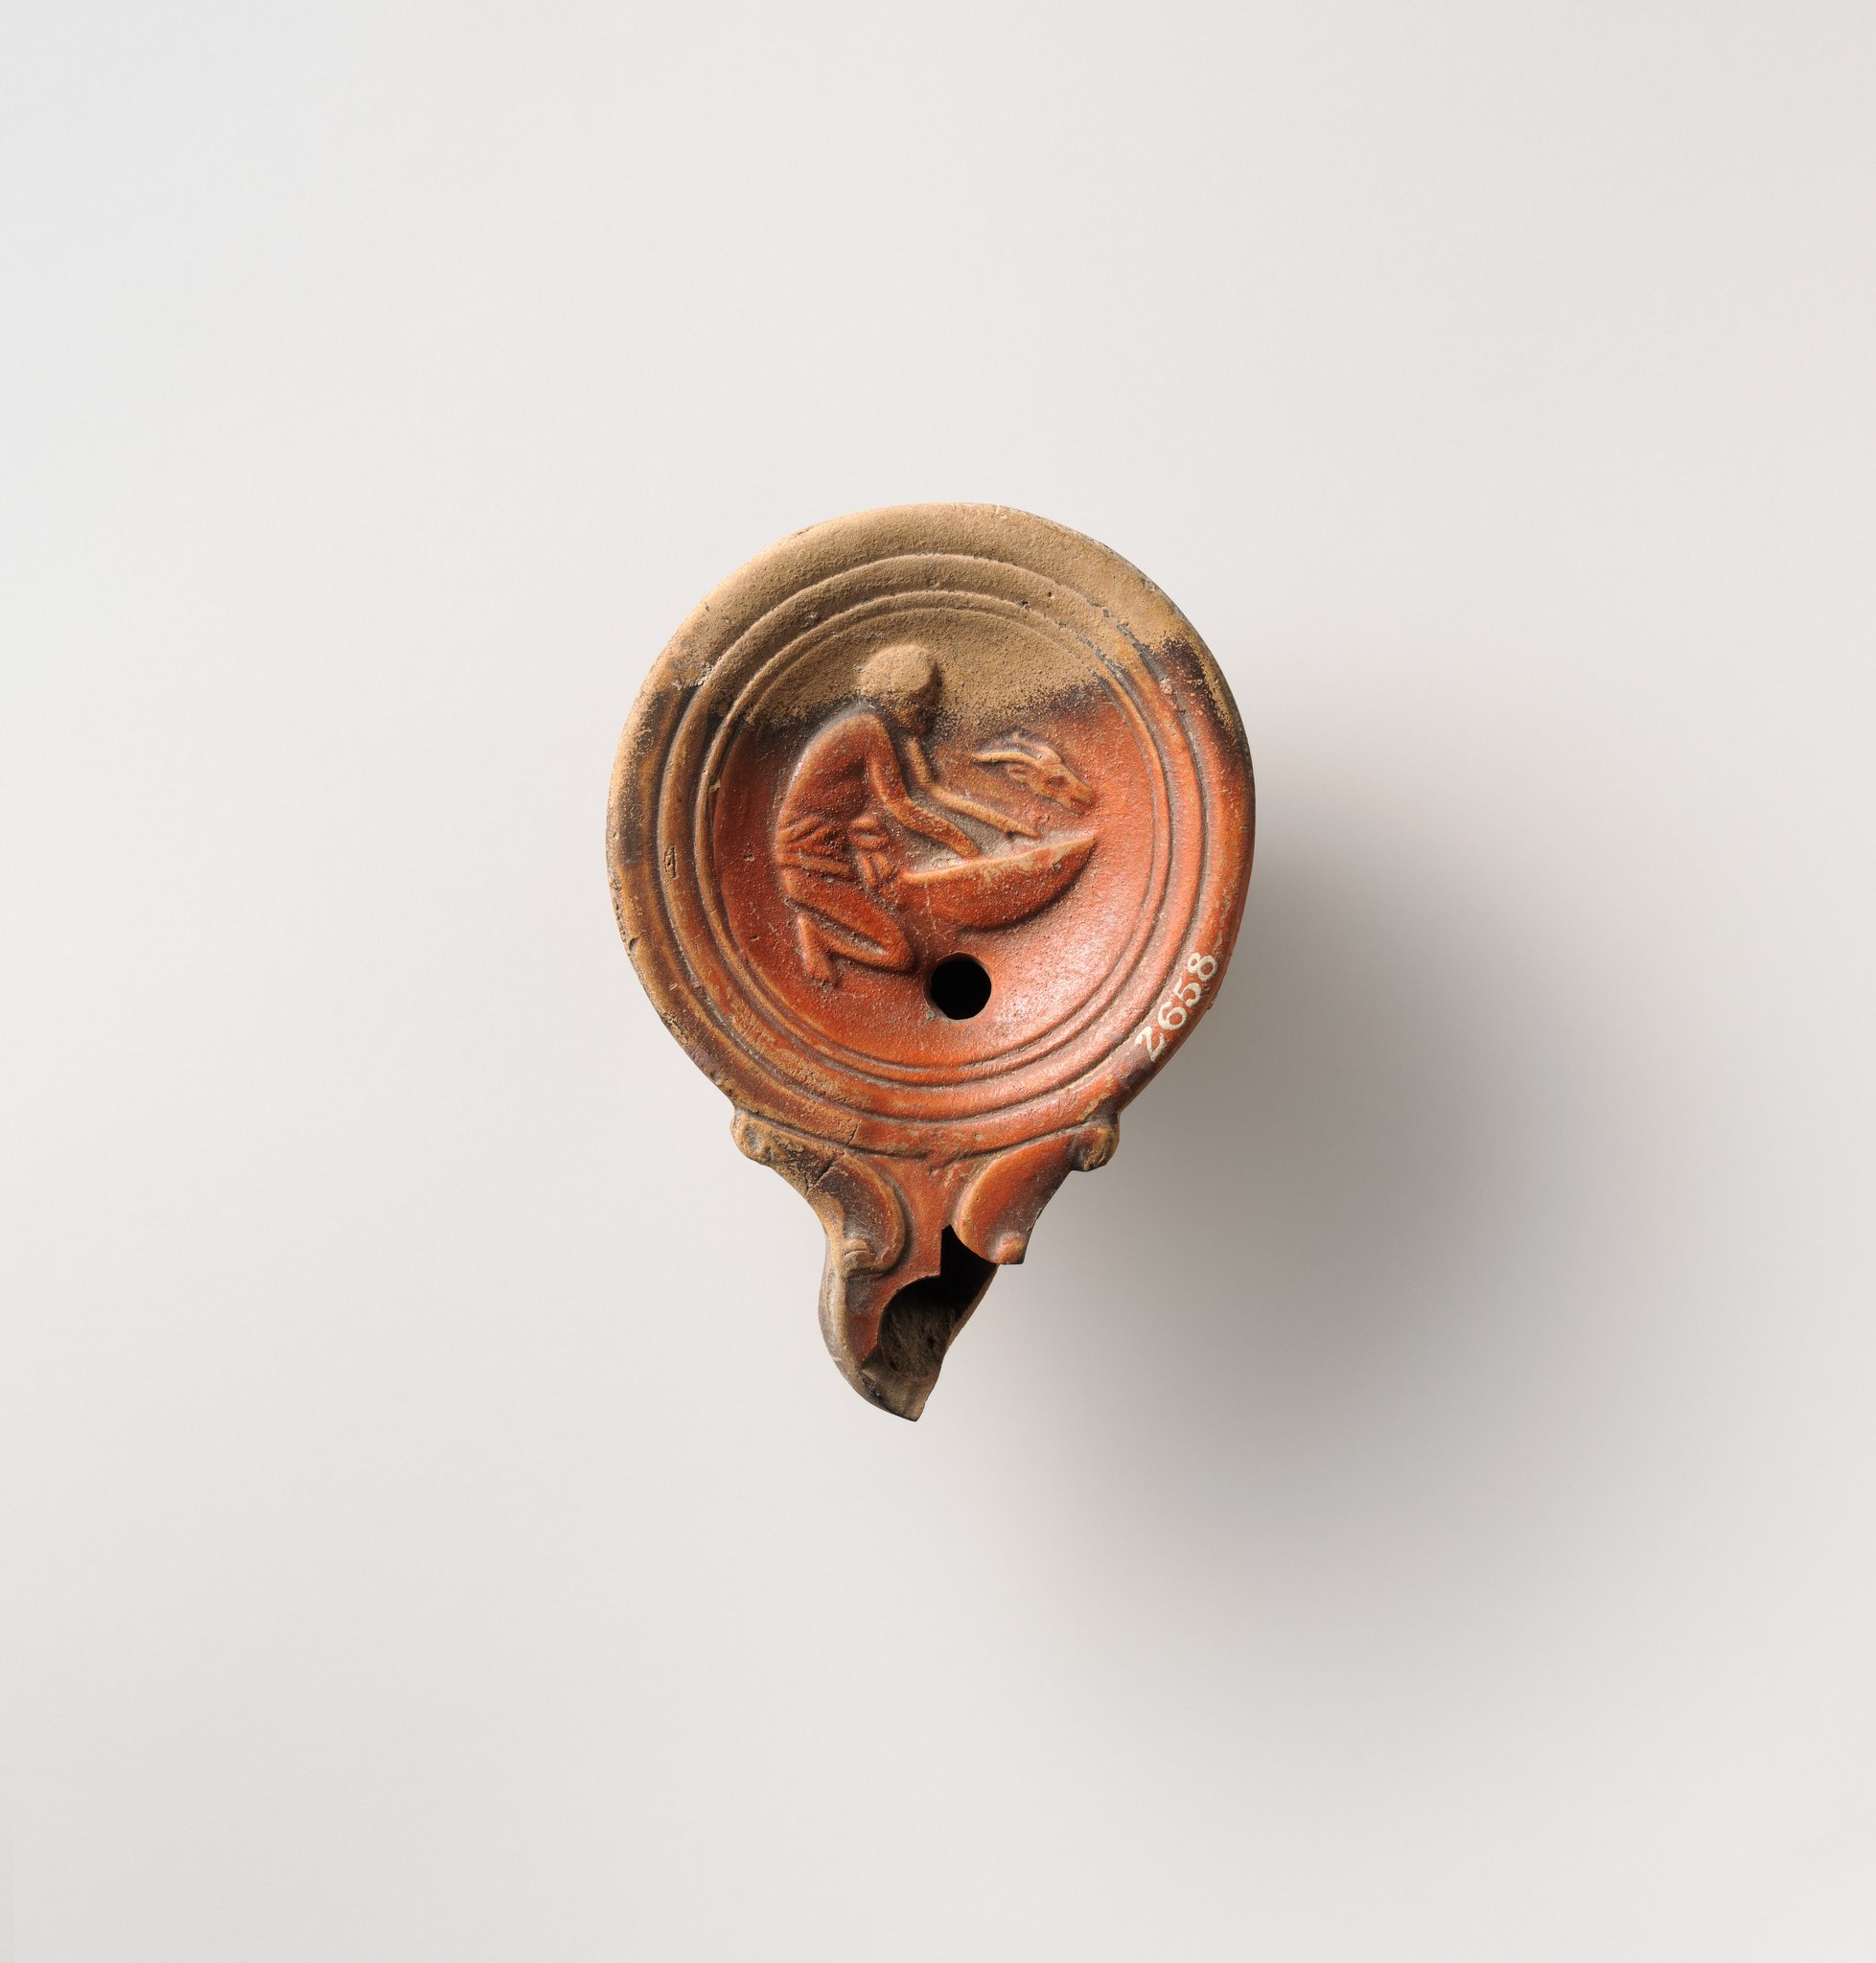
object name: lamp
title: Terracotta oil lamp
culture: roman, cypriot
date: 40-100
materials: terracotta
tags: men